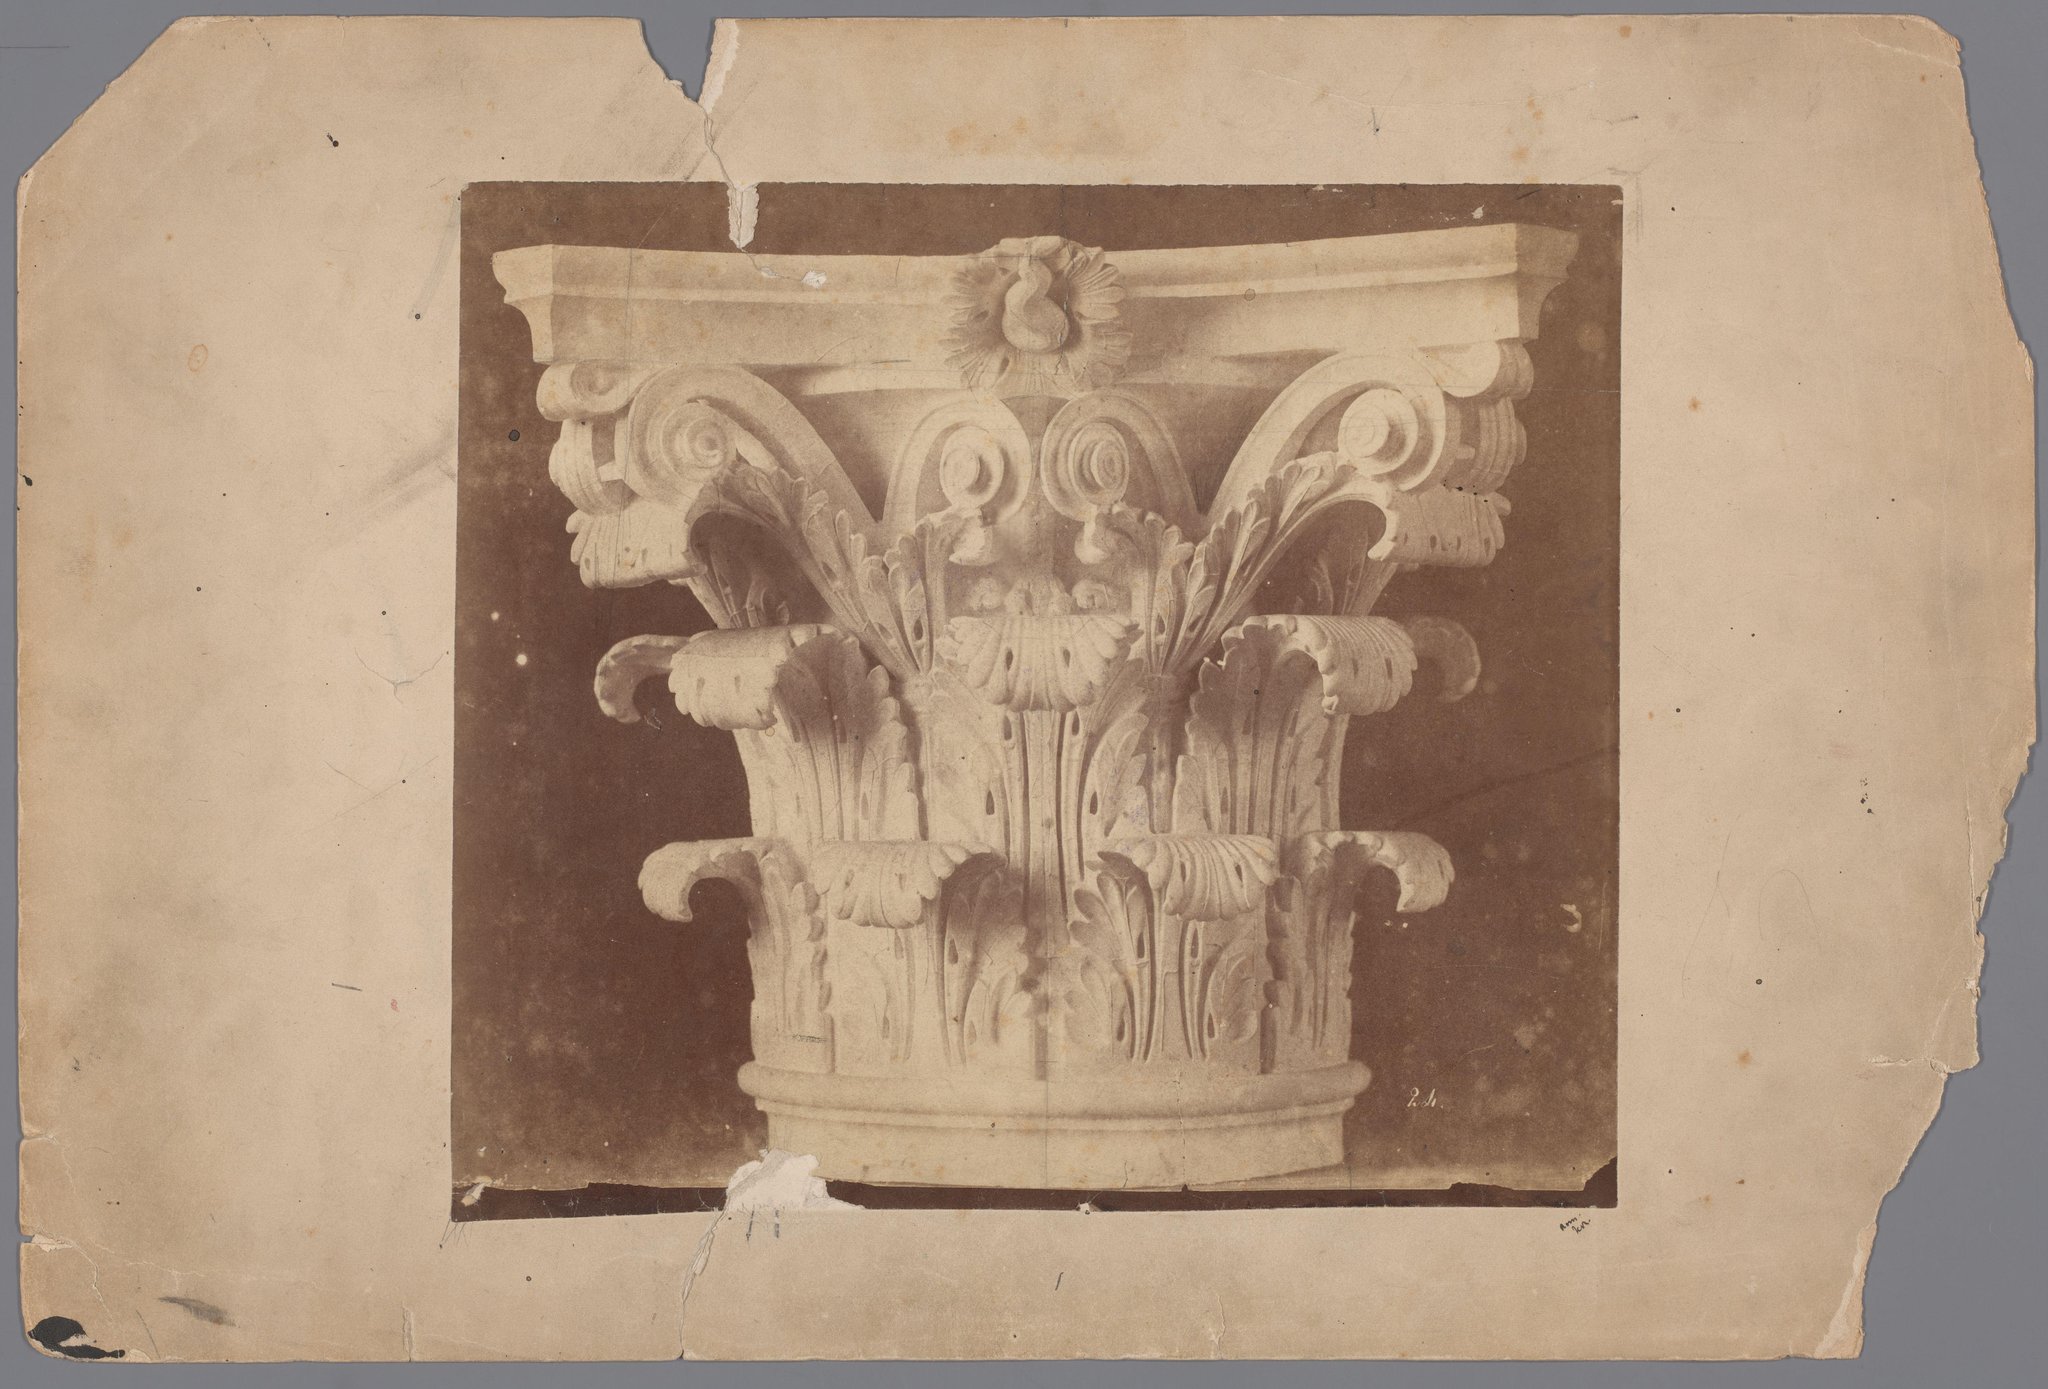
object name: photograph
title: Mogelijk afgietsel van een Korintisch kapiteel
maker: Anonymous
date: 1850-1900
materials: cardboard, photographic support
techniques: albumen print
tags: capital (~ column, pillar), corinthian order ~ architecture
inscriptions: collector's mark: ‘Rijks opleidingsinstituut/ voor teekenleeraren/ vrb hooger: middelb:/ & nijverheidsonderwijs/ Rijksmuseum/ Amsterdam’, collector's mark: Lugt 3937